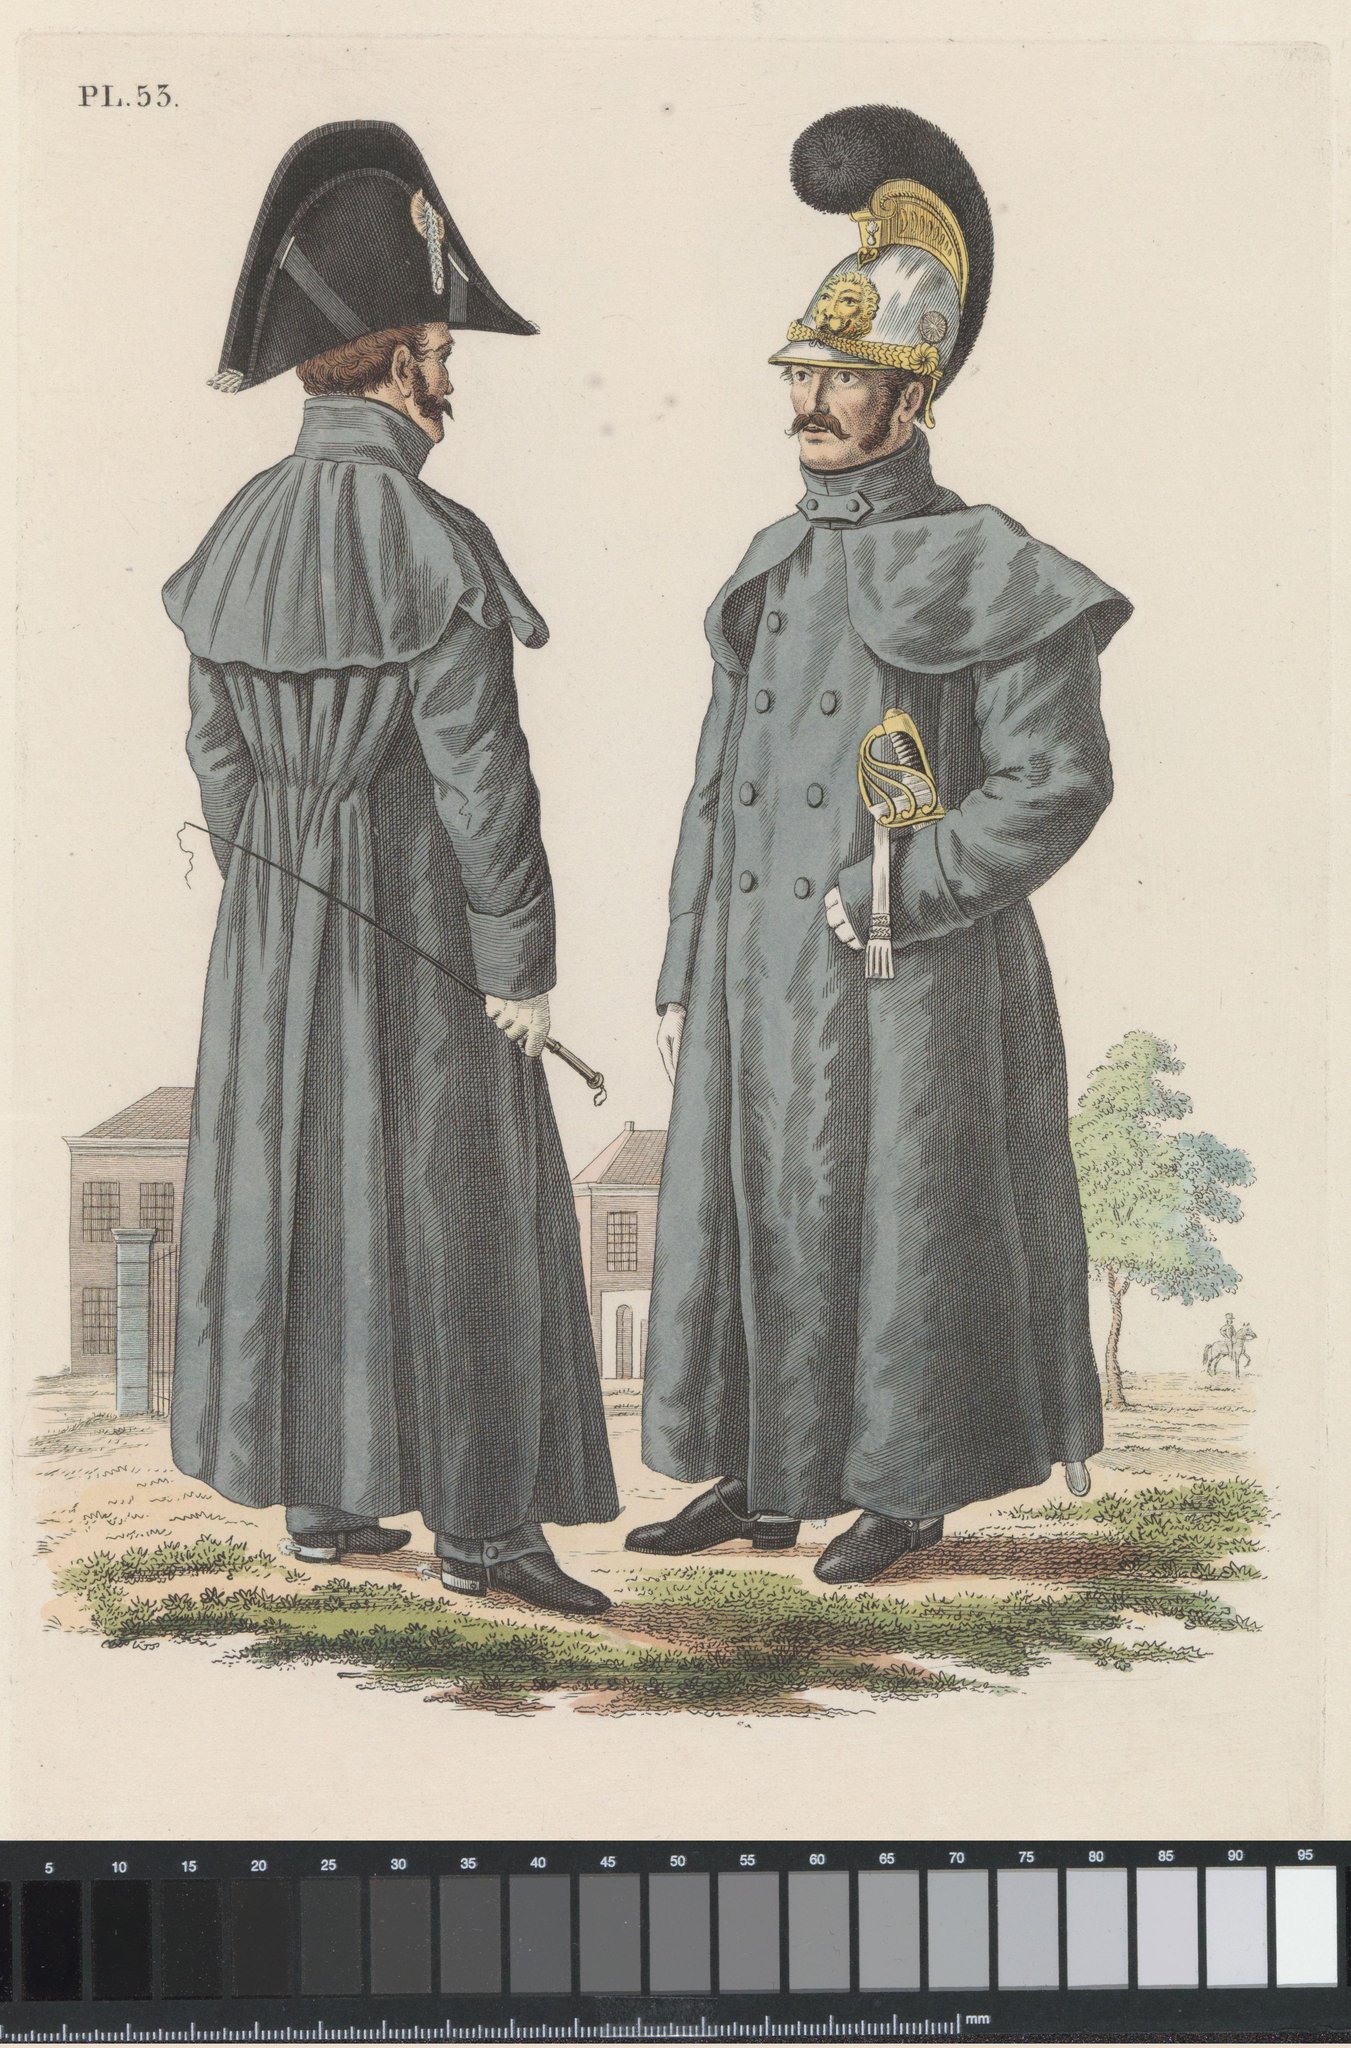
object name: print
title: Officier der Kurassiers, in kleine tenue met den manteljas, en Kurassier in tenue met den manteljas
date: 1826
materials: paper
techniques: engraving, etching, hand coloring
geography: the hague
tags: (military) uniforms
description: Twee Nederlandse kurassiers. Plaat 53. Uniformvoorstelling in 'Vervolg van de Beschrijving hoedanig de Koninklijke Nederlandsche troepen' van J.F. Teupken, 1826.